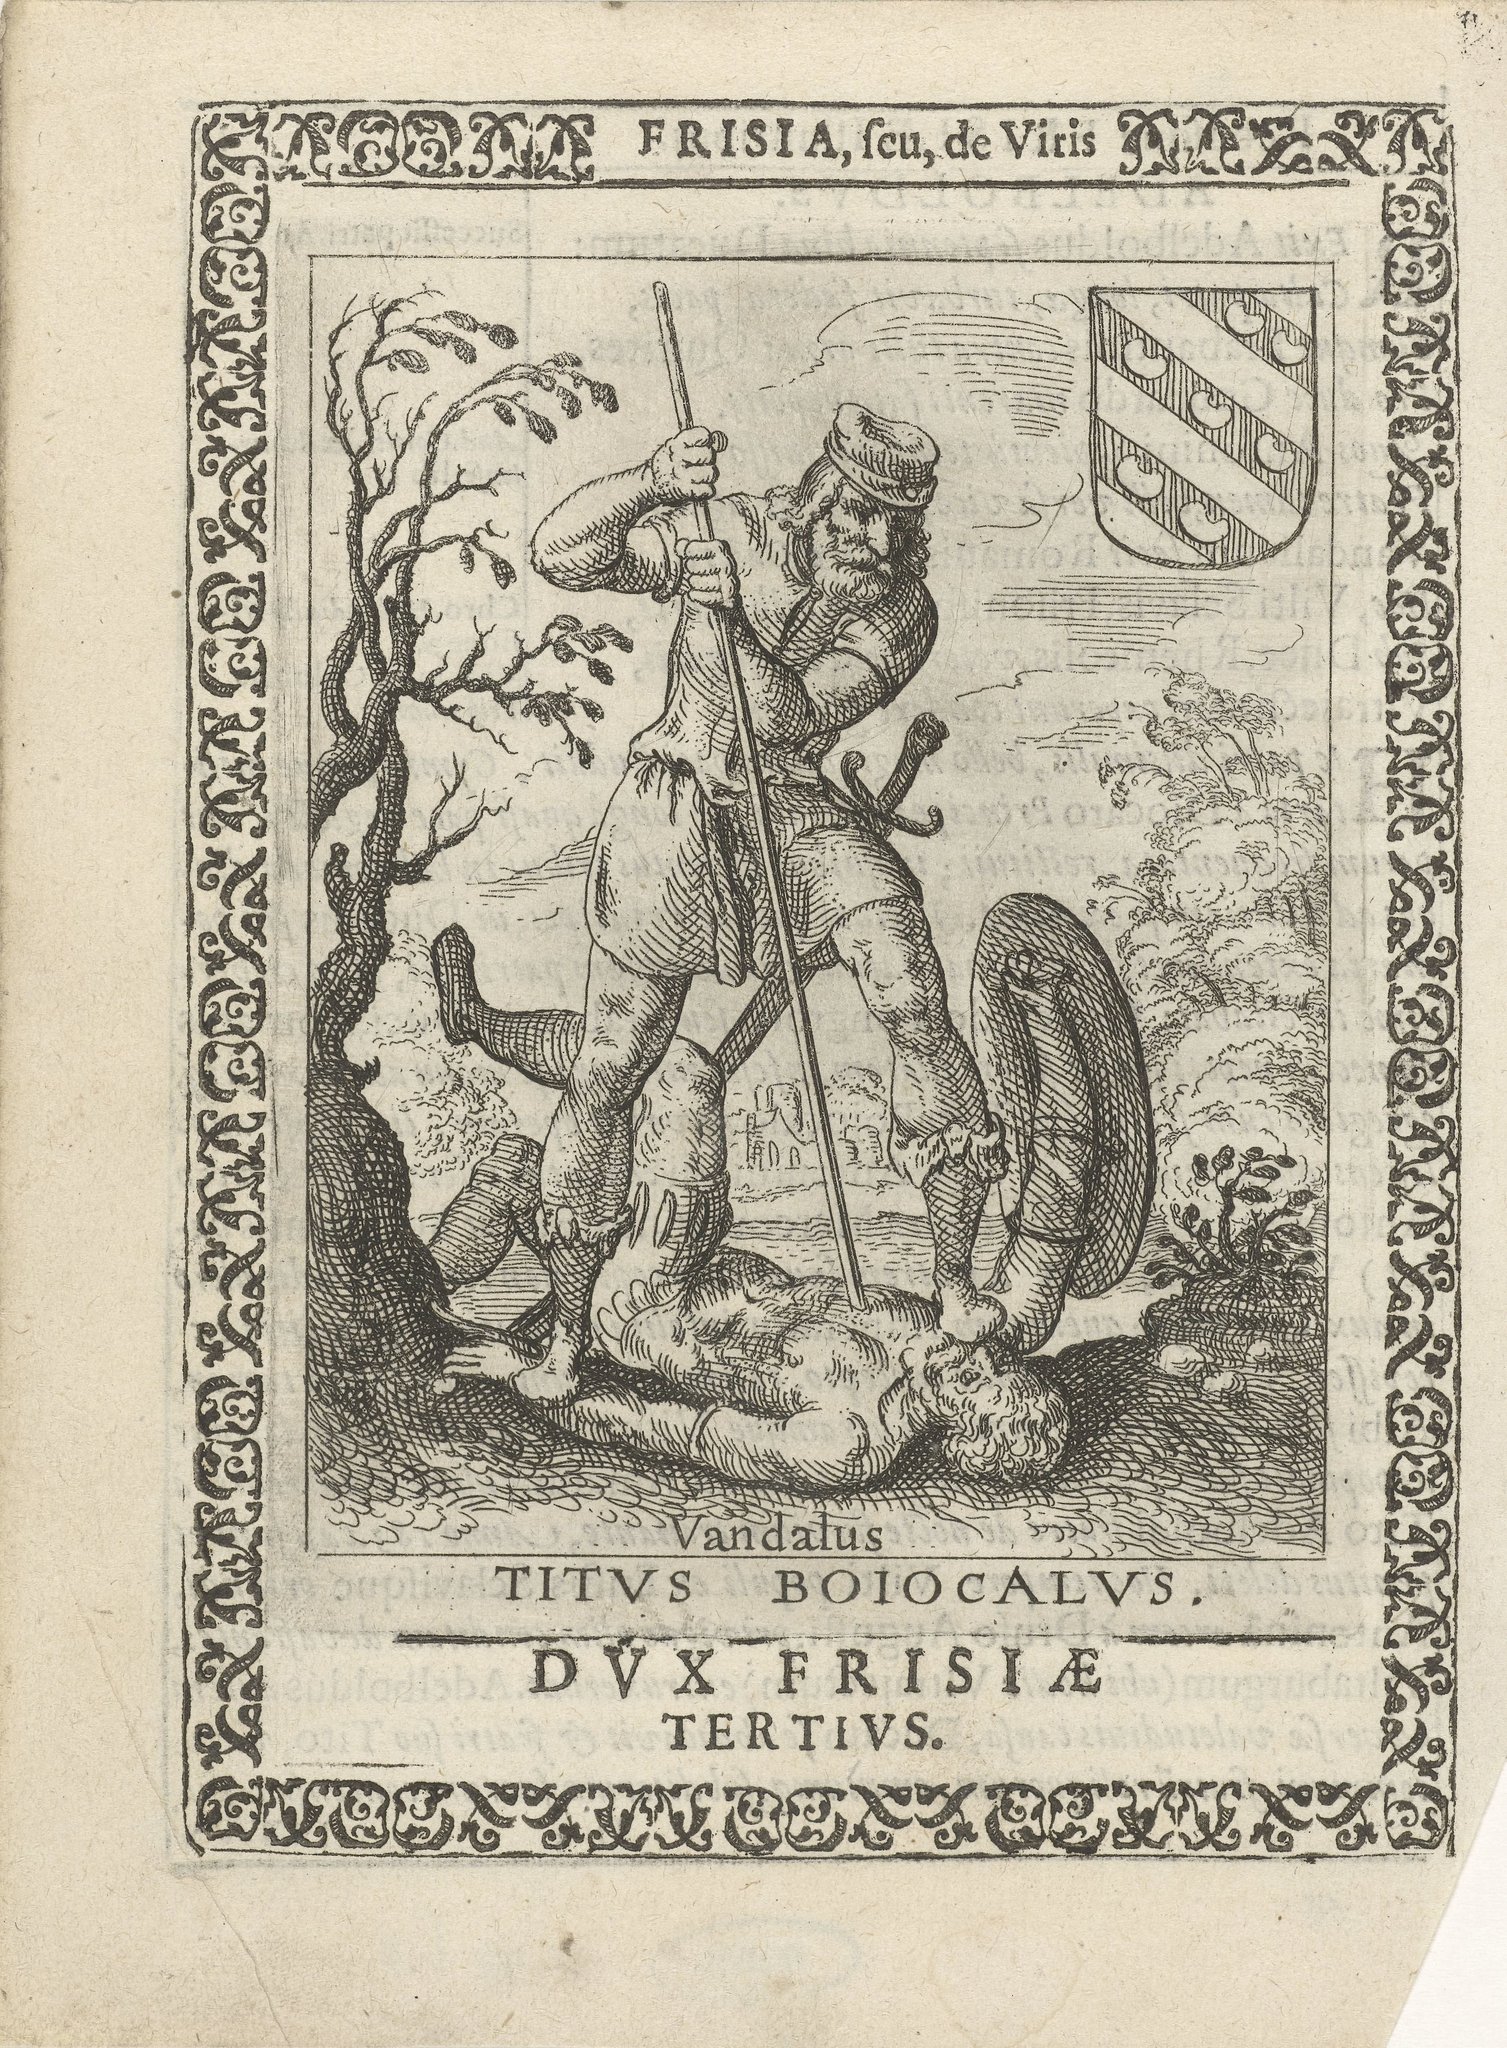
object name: print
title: Titus Bojocalis, derde hertog der Friezen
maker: pieter feddes van harlingen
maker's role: painter, print maker, publisher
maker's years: 1586-1623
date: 1618-1620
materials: paper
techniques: etching, letterpress printing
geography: friesland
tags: ruler, sovereign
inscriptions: collector's mark: Lugt 2228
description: Titus Bojocalis, derde hertog der Friezen. Staande ten voeten uit, doorsteekt met een lans een op de grond liggende tegenstander. In een ornamentale omlijsting. Illustratie, met tekst op achterzijde, afkomstig uit het boek: Frisia seu de viris rebusque Frisiae illustribus libri duo.